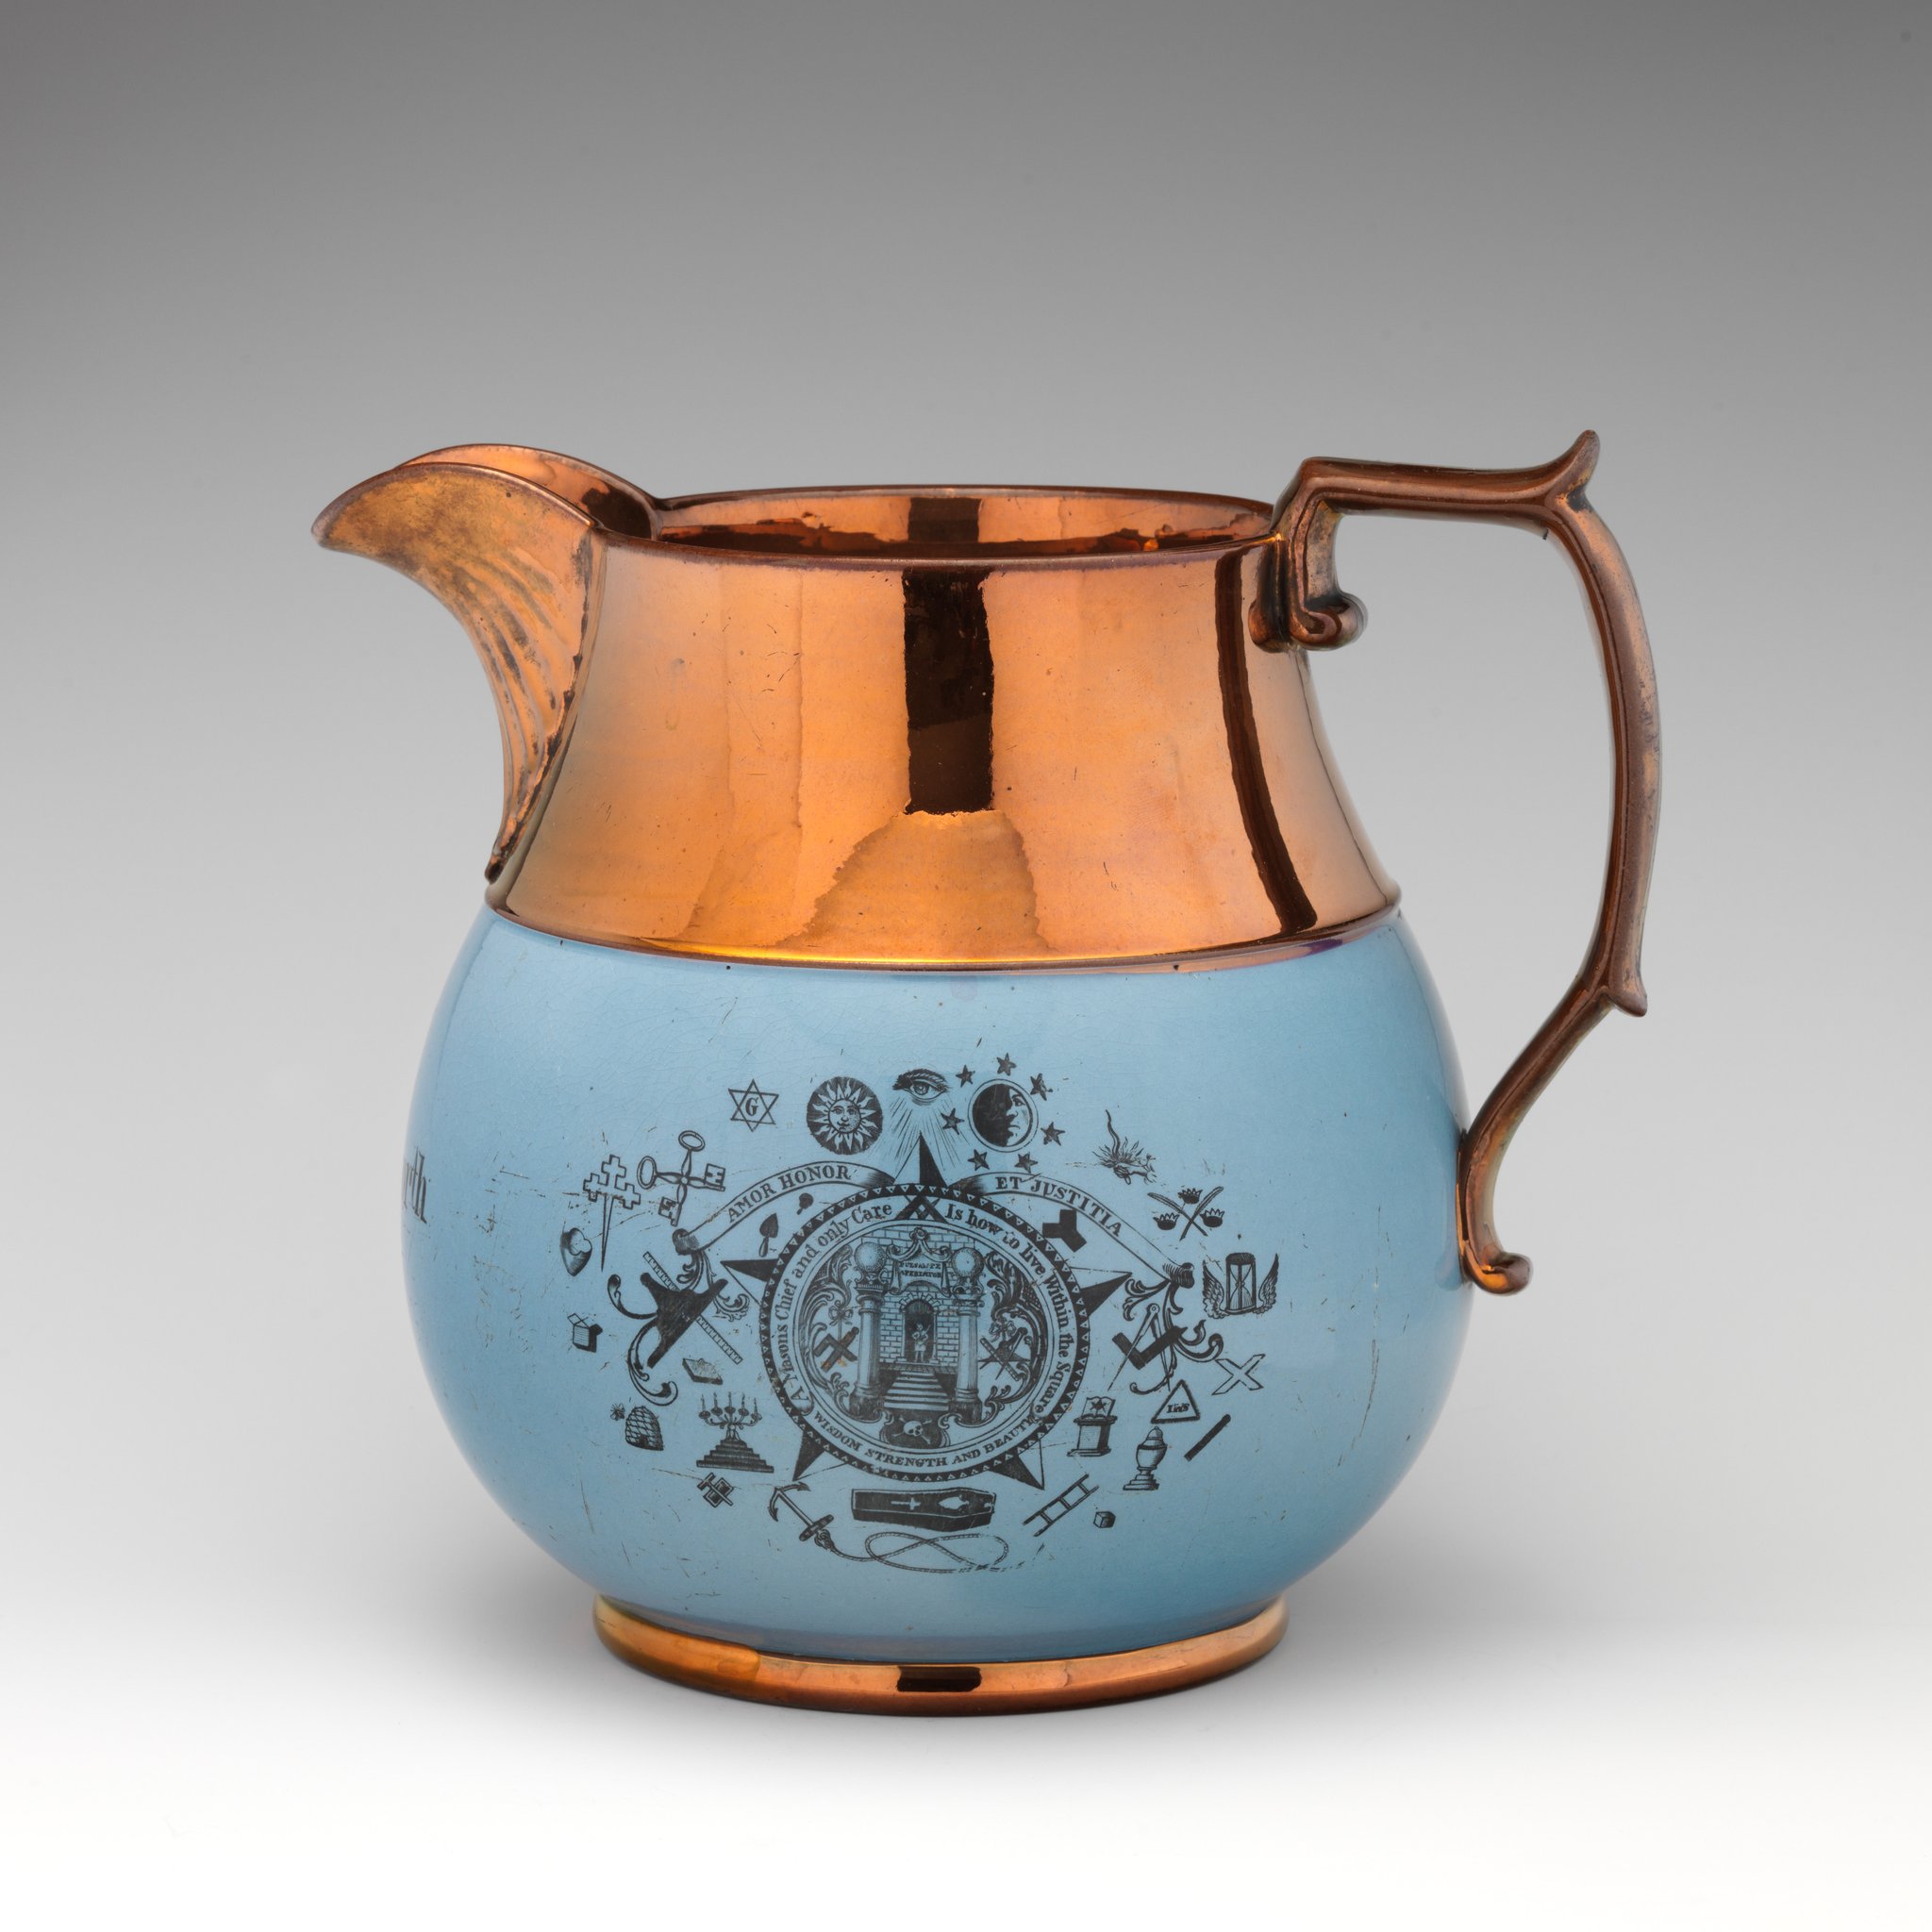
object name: jug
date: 1810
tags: coat of arms